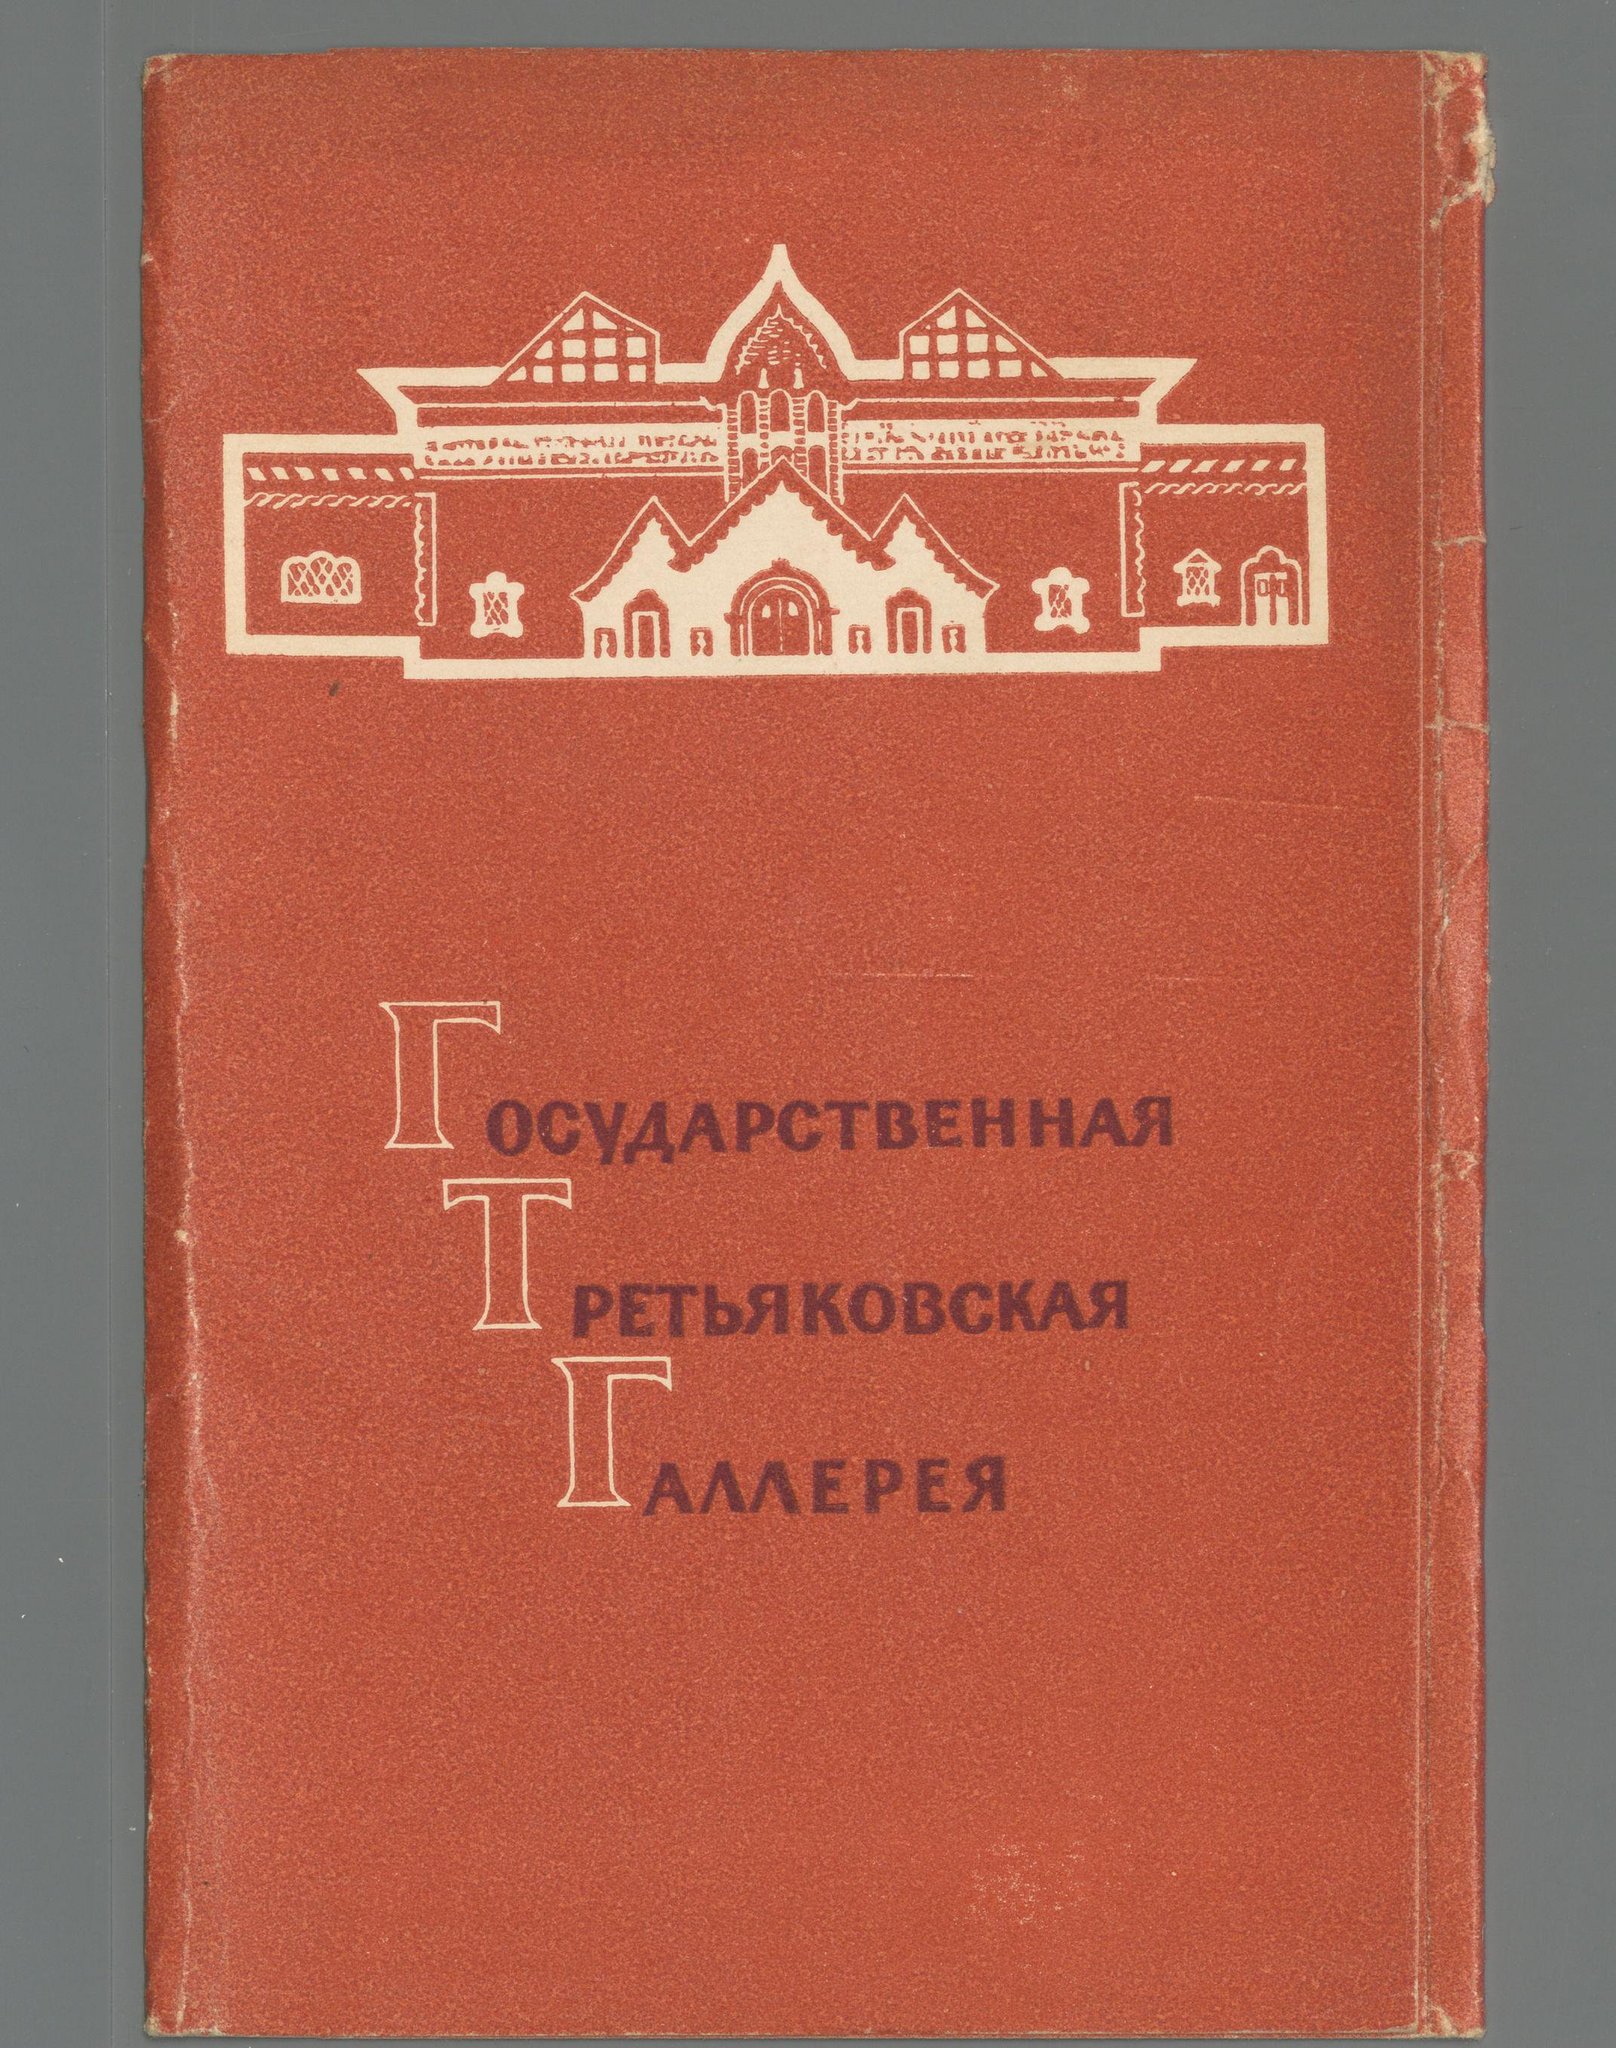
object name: photomechanical print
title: Omslag voor twaalf fotobriefkaarten met kunstreproducties uit de Tretjakovgalerij te Moskou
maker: Anonymous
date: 1956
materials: cardboard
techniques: printing block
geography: moscow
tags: permanent exhibition, museum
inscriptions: date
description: De titel op object staat in het Russisch.